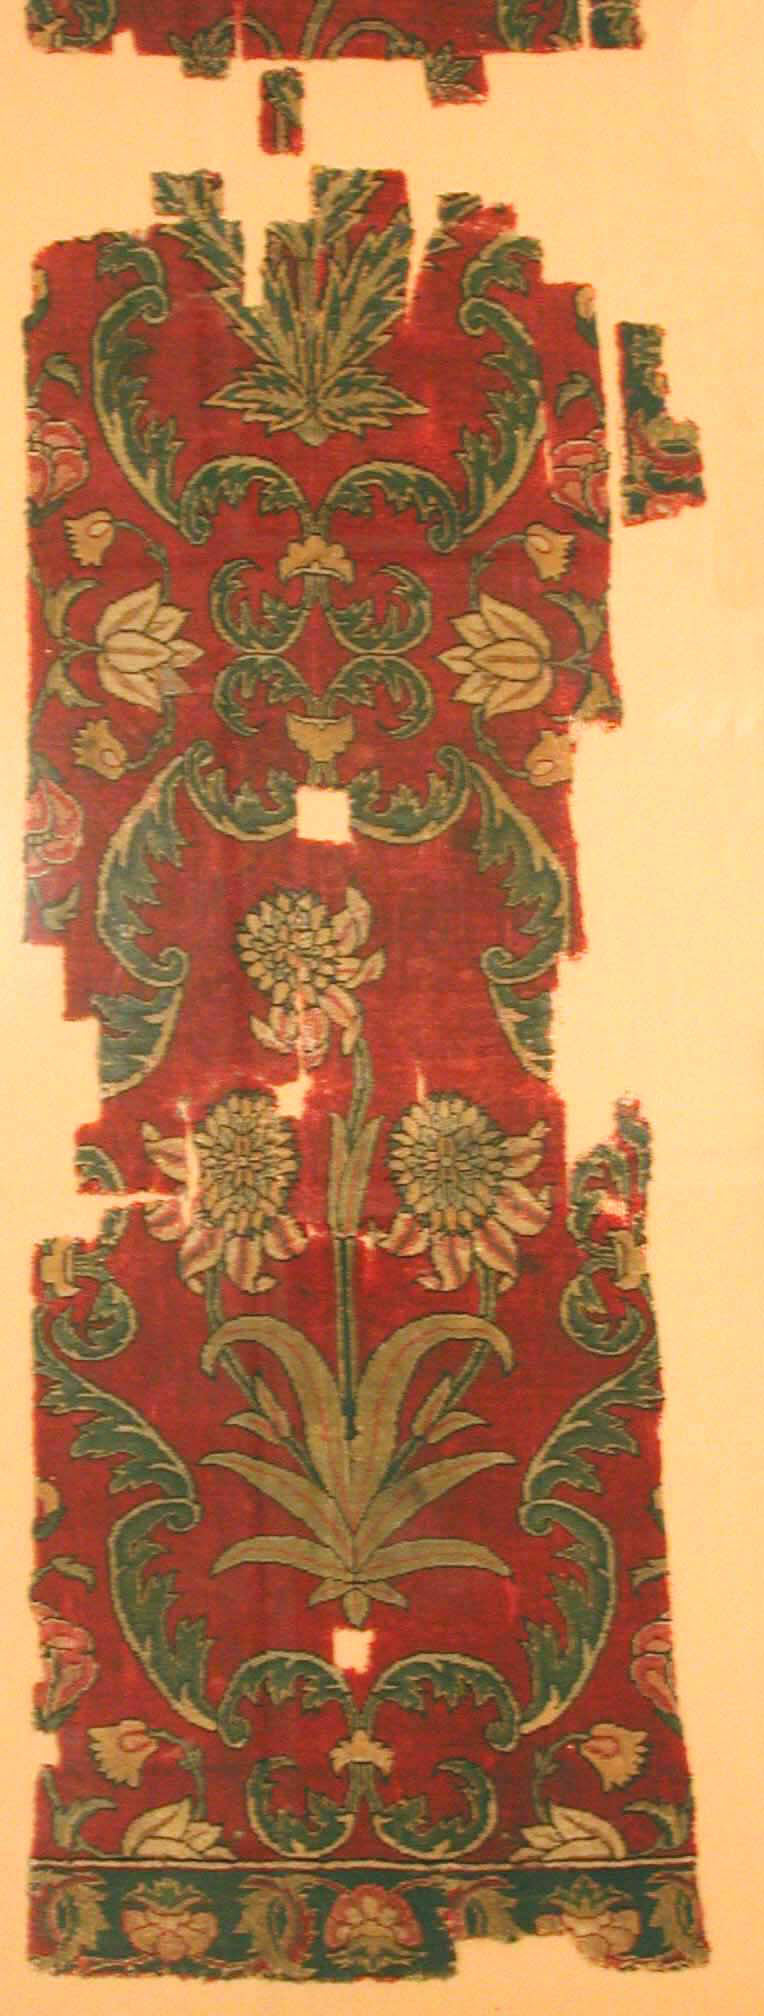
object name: carpet fragment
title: Carpet Fragments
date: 1601-1700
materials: silk, wool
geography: india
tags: flowers